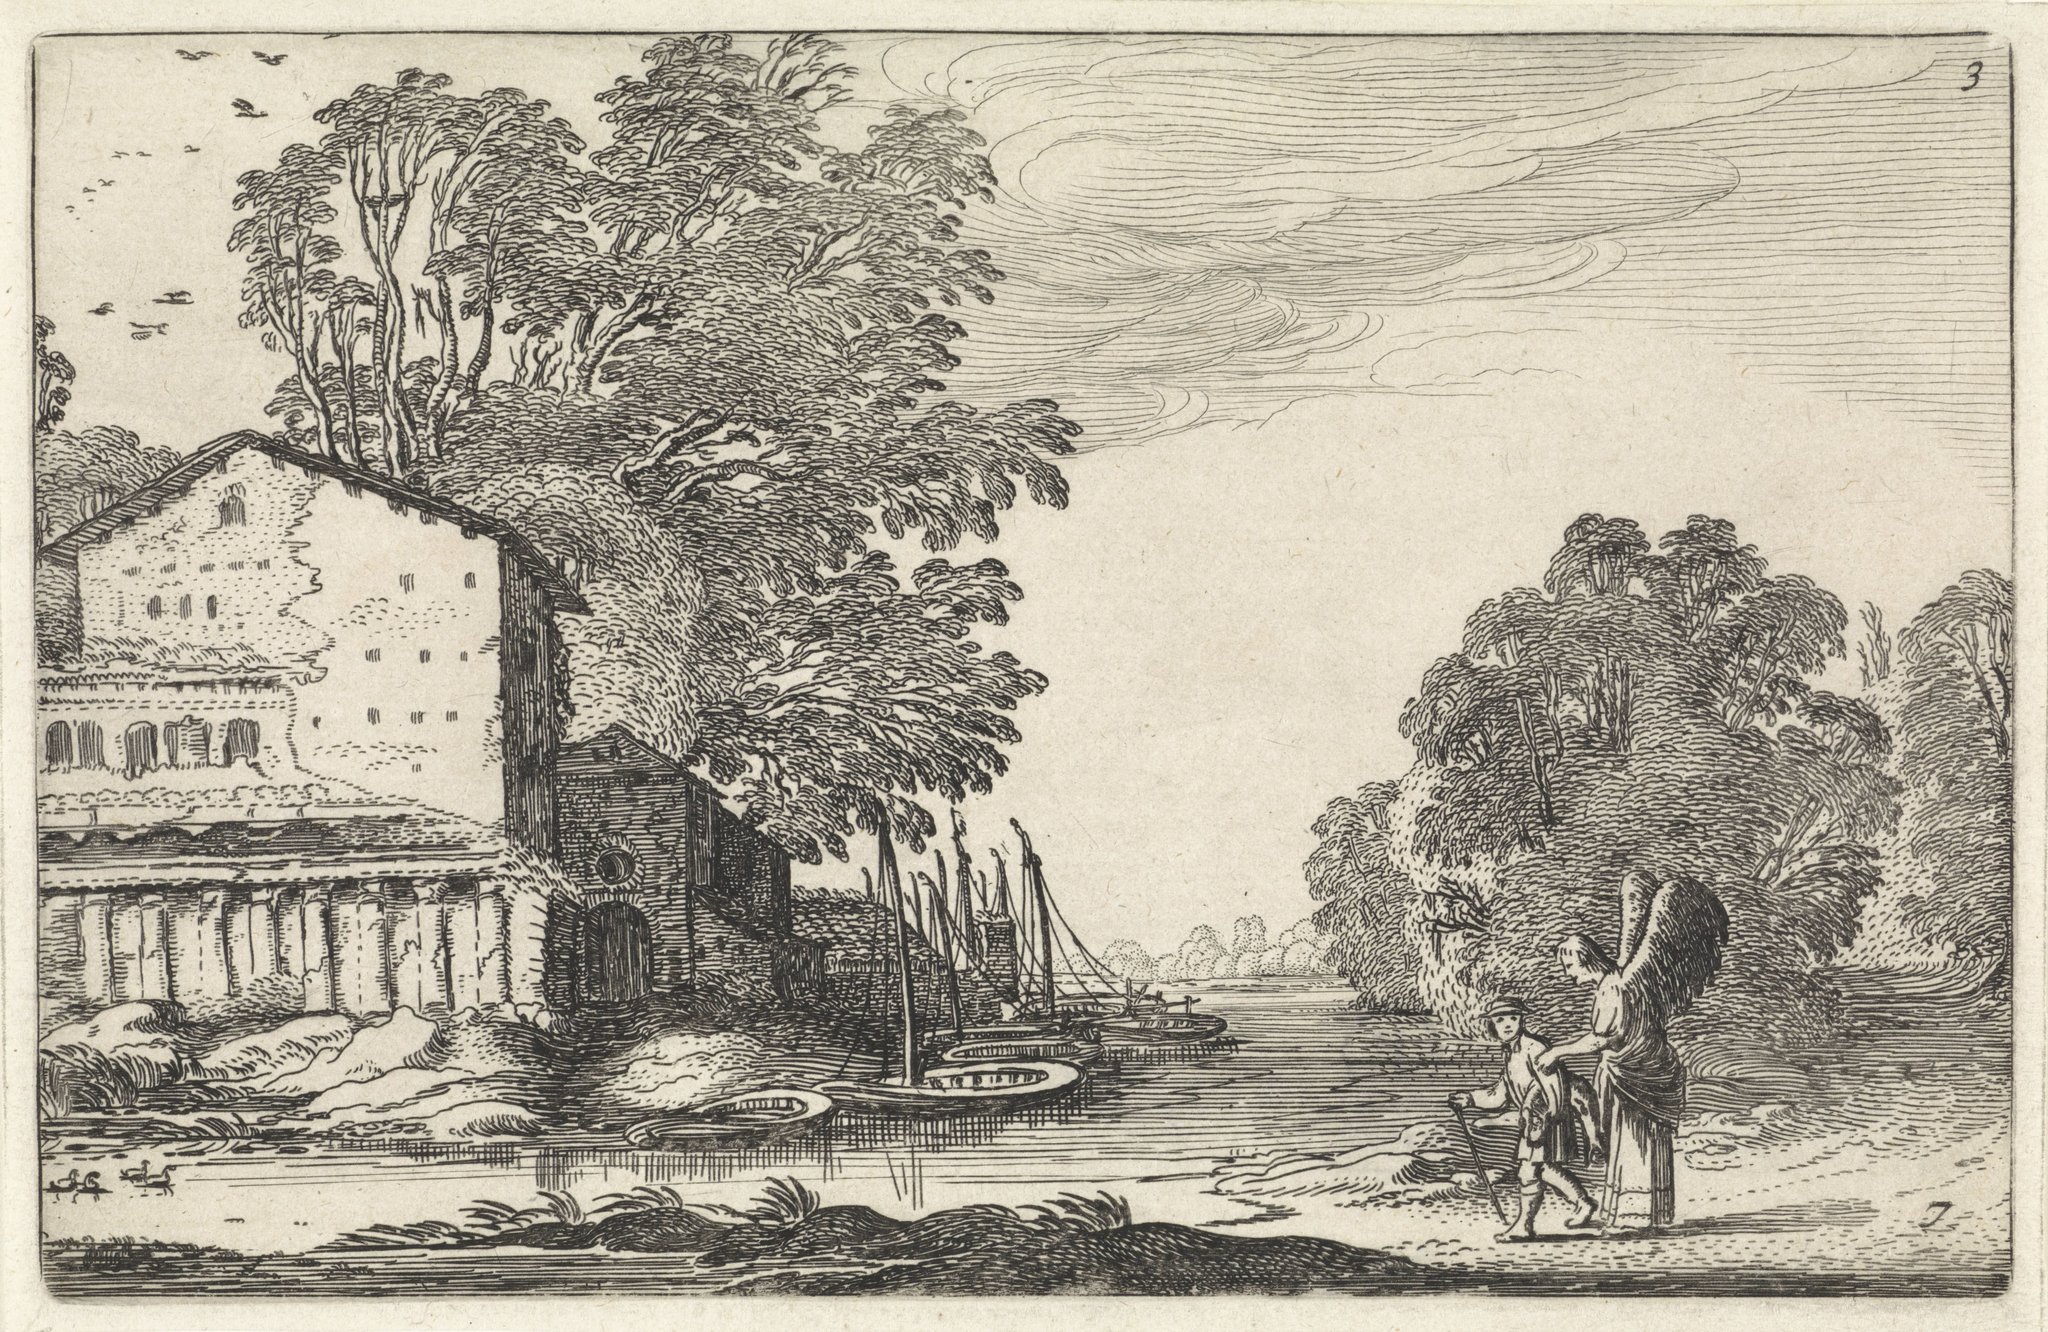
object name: print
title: Amenissimae aliquot requculae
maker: jan van de velde (ii)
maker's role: draughtsman, painter, print maker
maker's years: 1593-1641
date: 1616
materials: paper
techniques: etching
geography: northern netherlands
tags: river, landscape with ruins, tobias and the angel raphael continue their journey; usually tobias carrying the fish, ruin of a dwelling, house, castle, etc.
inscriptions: collector's mark: Lugt 964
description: Tobias, met onder zijn arm de vis, en de engel onderweg op een pad in een landschap met een ruïne van een huis (Tobit 4-6). Aangemeerde boten langs de oever. Zevende prent van deel drie van een serie van in totaal zestig prenten met landschappen, verdeeld over vijf delen van elk twaalf prenten.